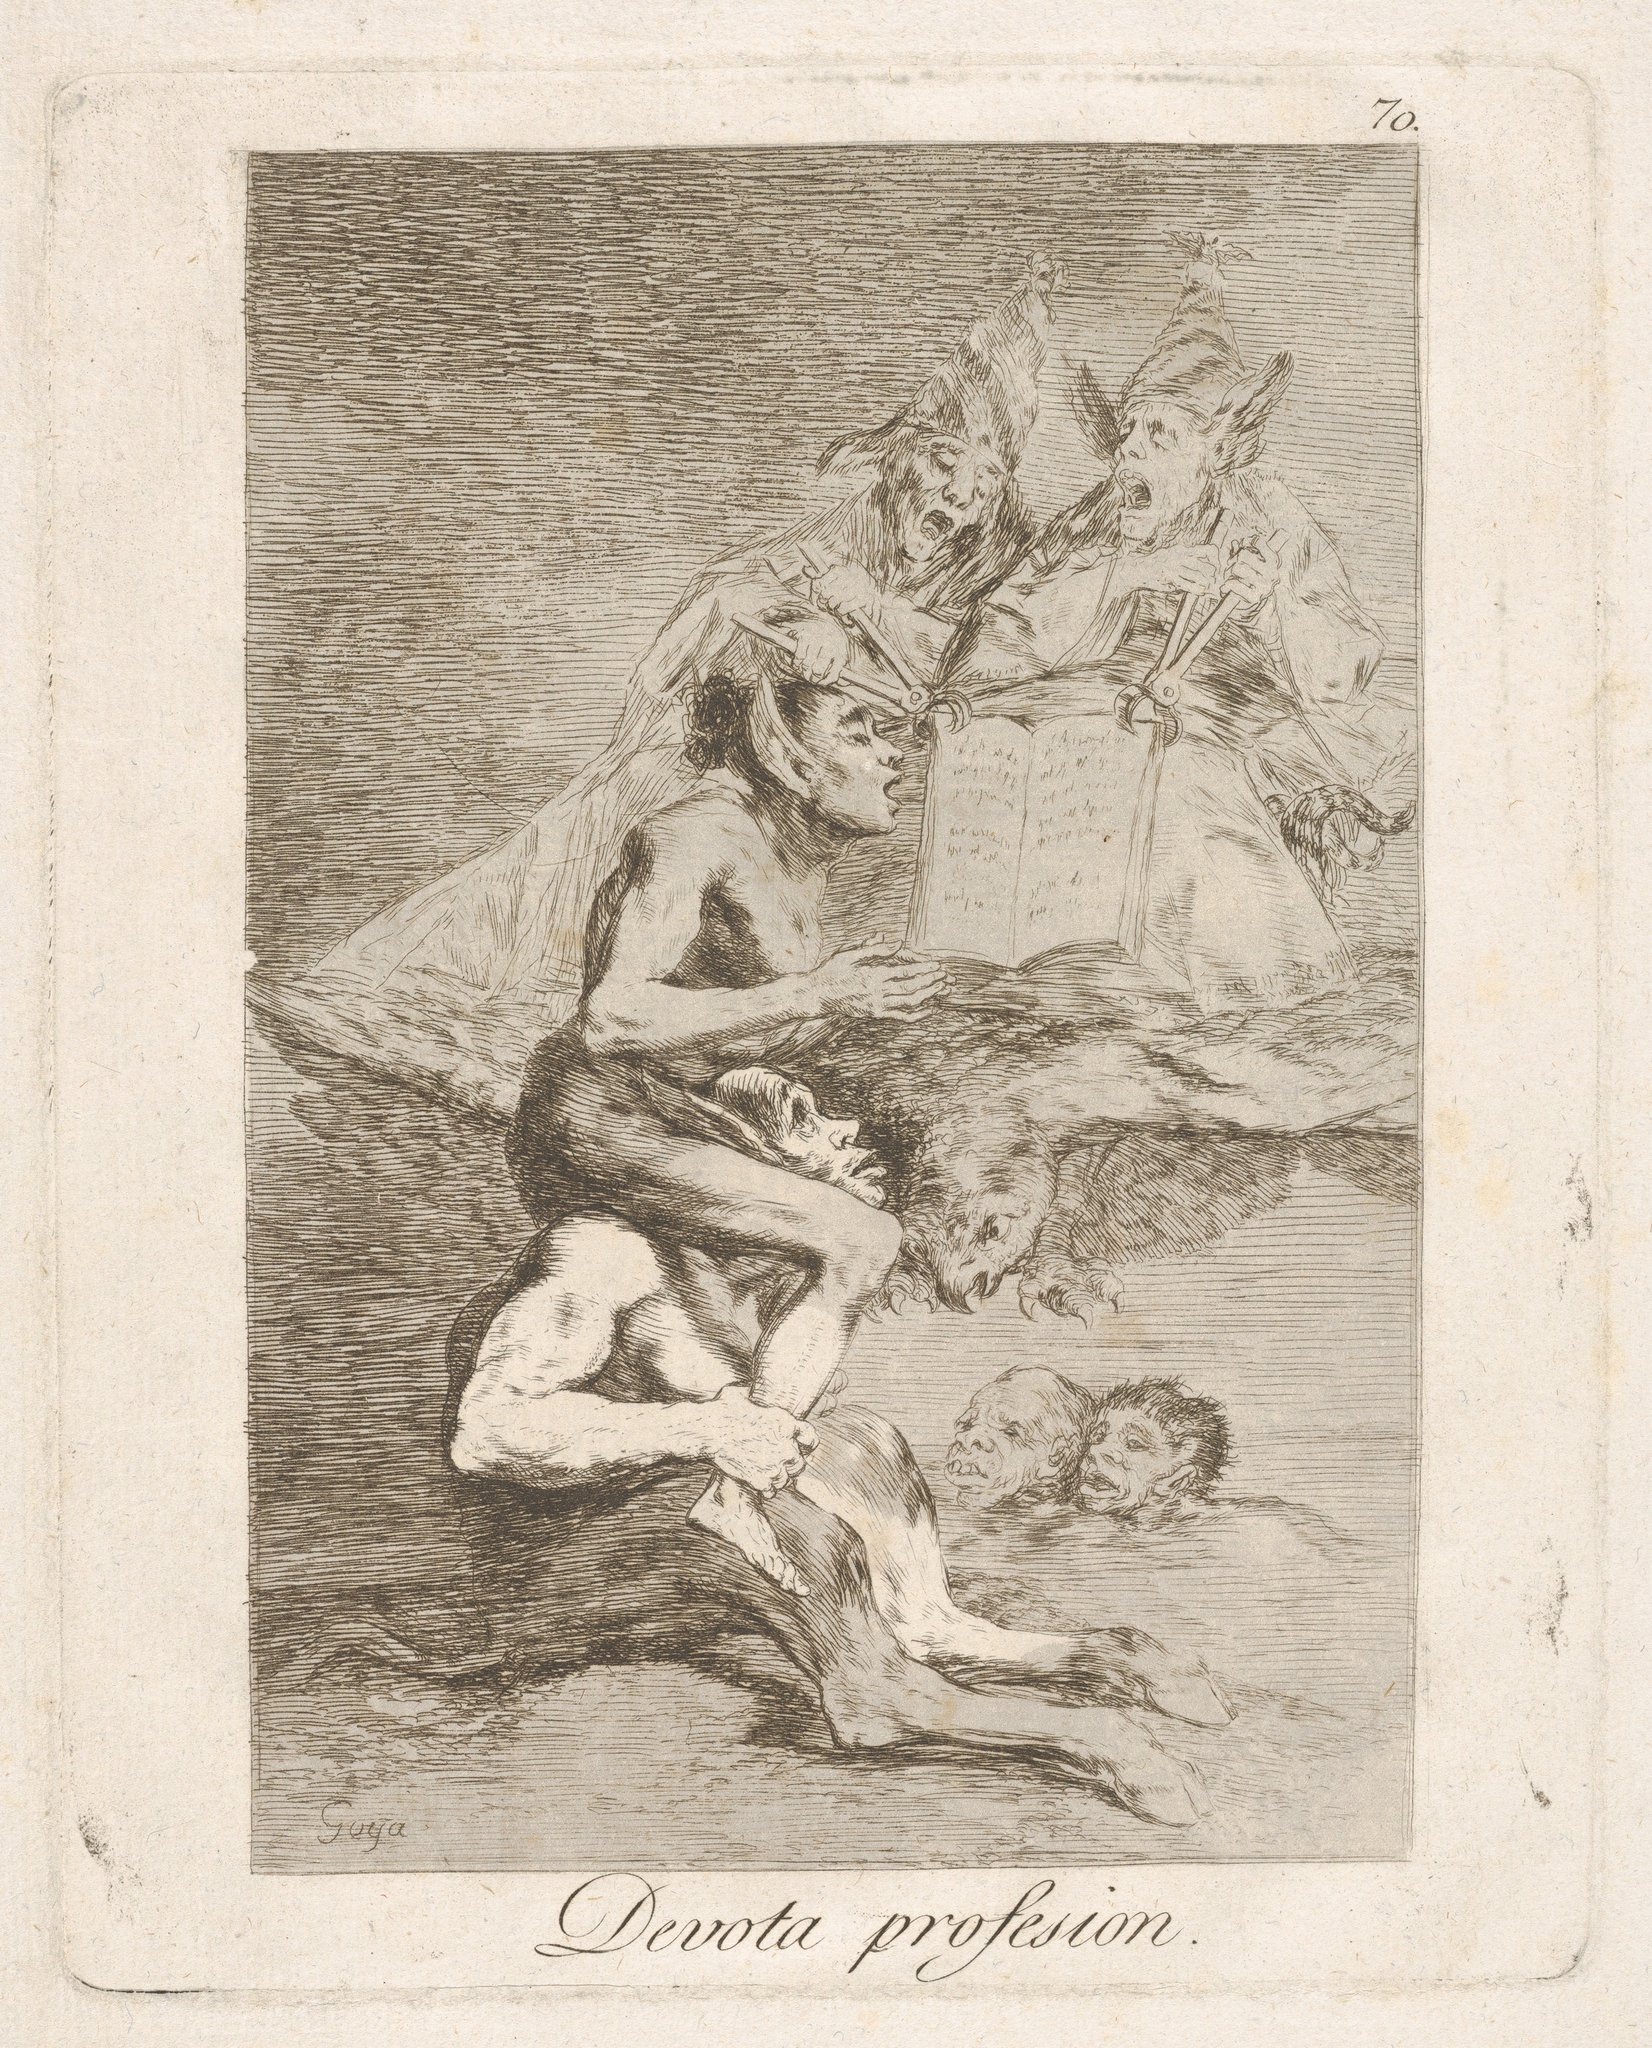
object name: print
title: Plate 70: Devout Profession (Devota Profesion), from "Los Caprichos"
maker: goya (francisco de goya y lucientes)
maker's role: artist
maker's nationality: spanish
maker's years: 1746-1828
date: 1799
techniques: aquatint, drypoint, etching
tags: reading